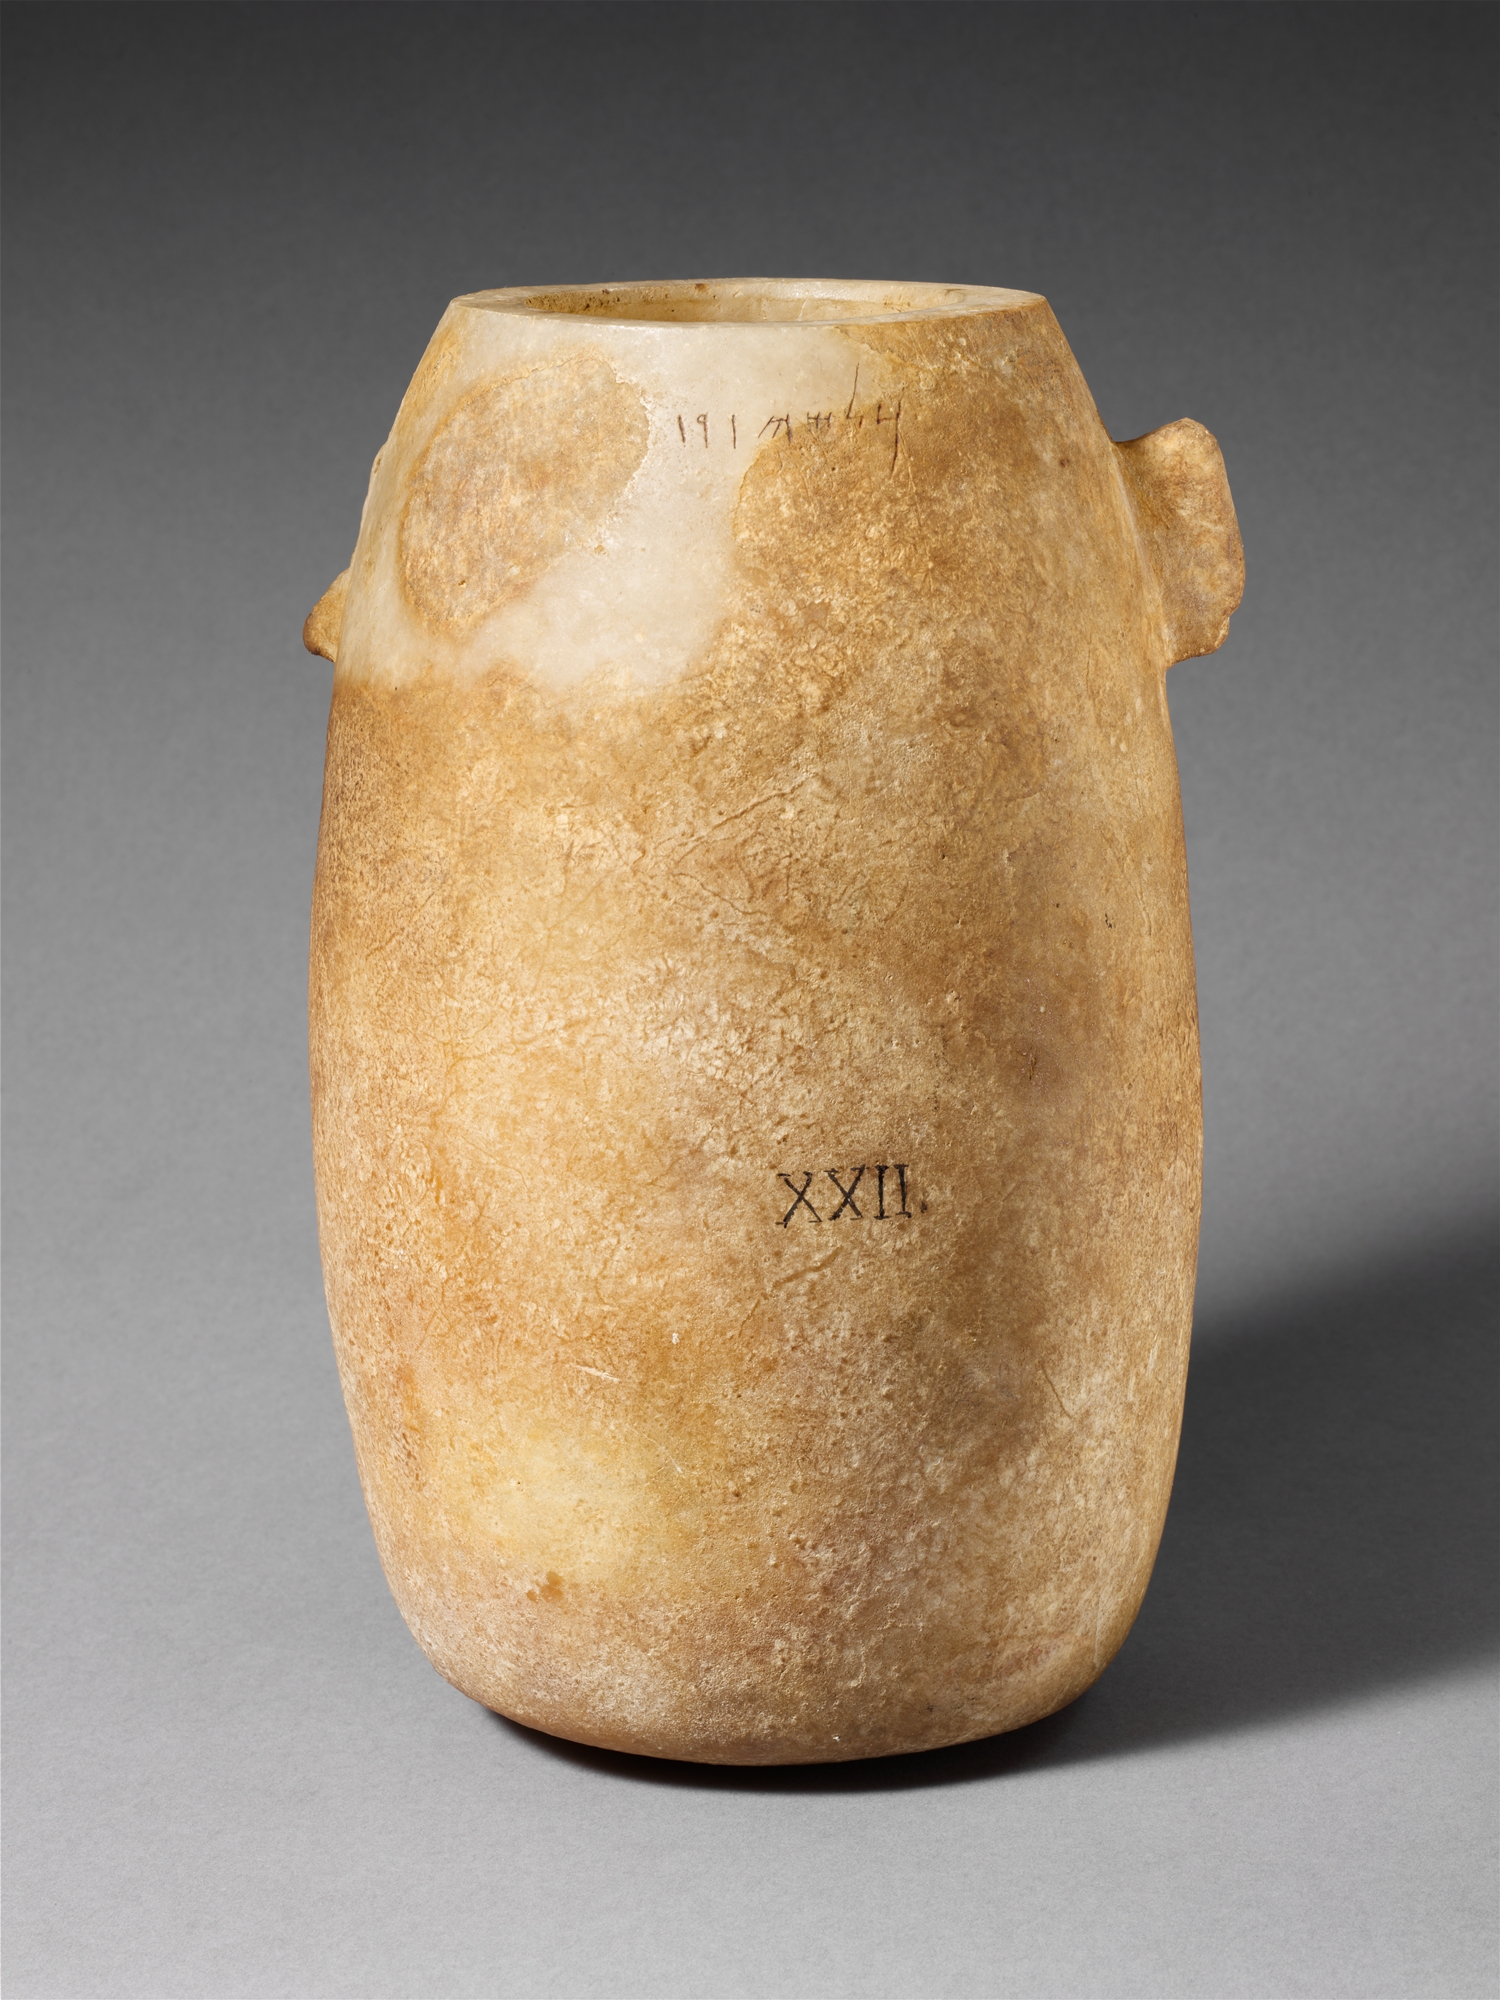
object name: vase with inscription, phoenician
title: Alabaster inscribed "alabastron"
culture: cypriot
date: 400-301 BCE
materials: alabaster